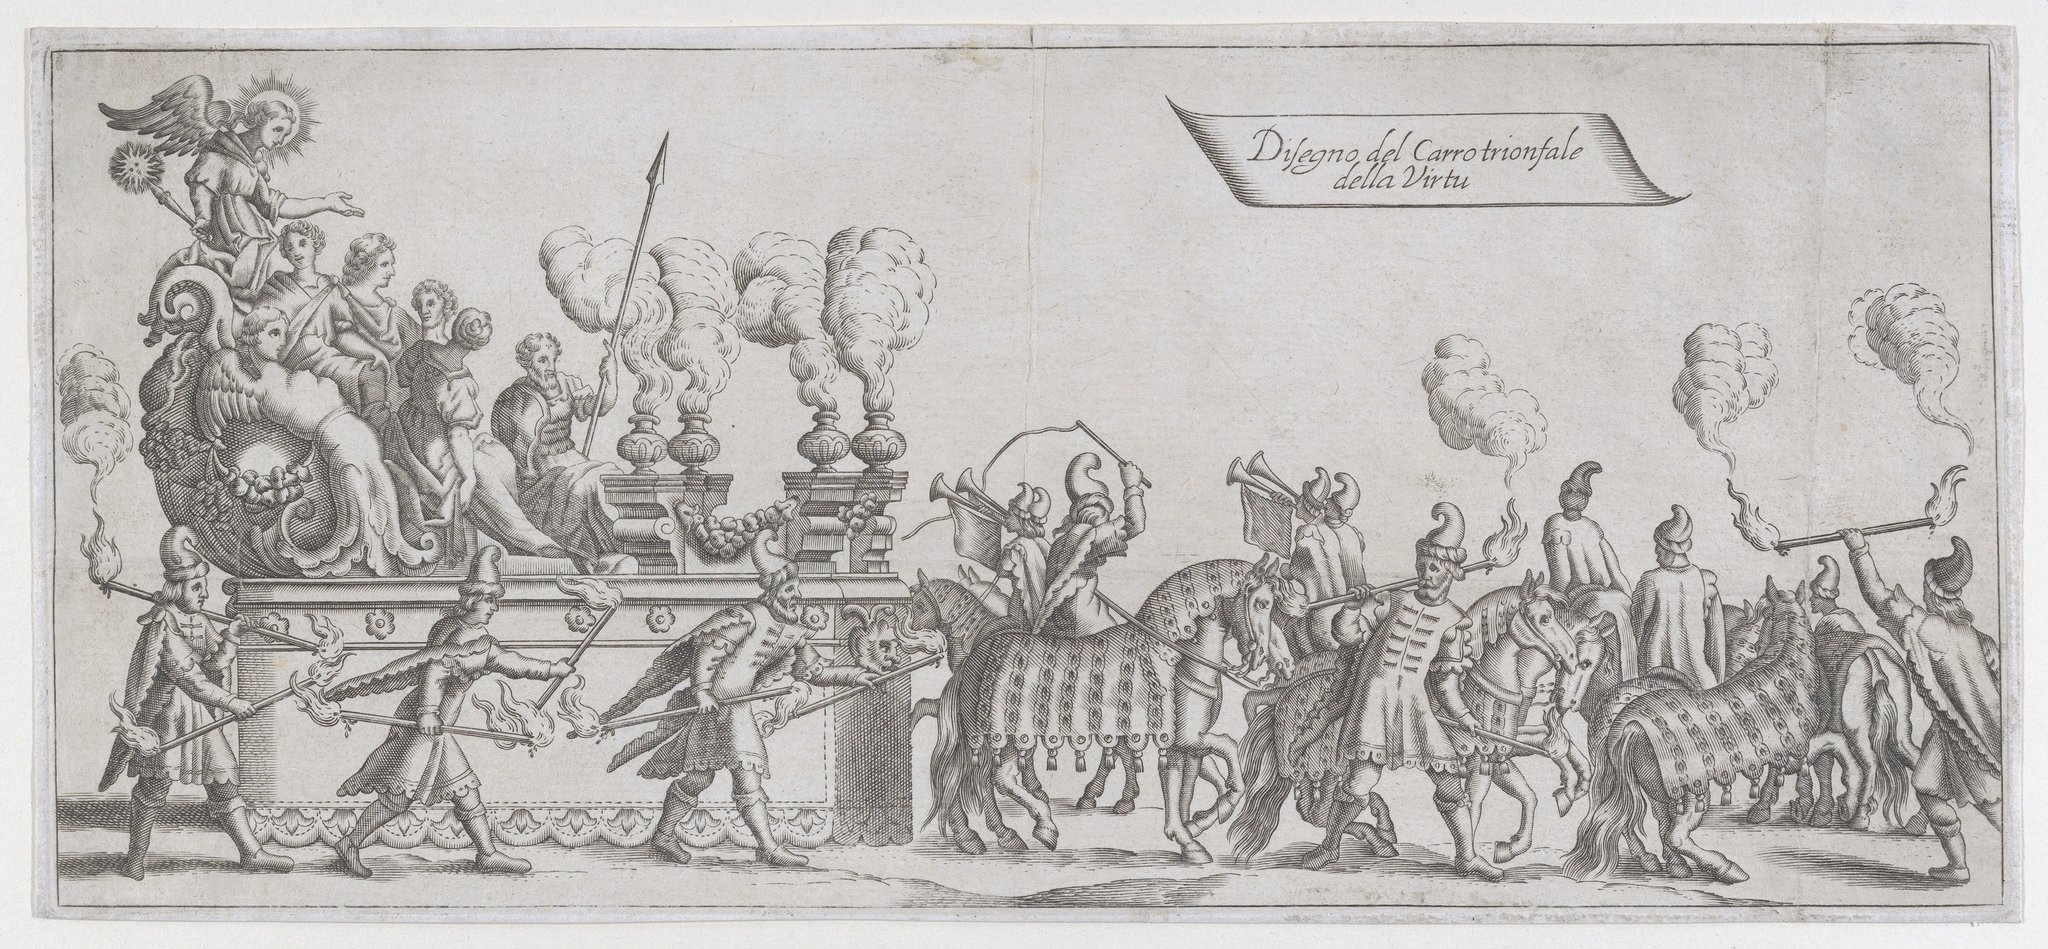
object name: print, fete, ornament architecture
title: Design of the triumphal chariot of the Virtues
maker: anonymous, italian, 17th century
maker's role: artist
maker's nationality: italian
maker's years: 1600-1700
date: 1601-1700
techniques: engraving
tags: men,women,horses,chariots